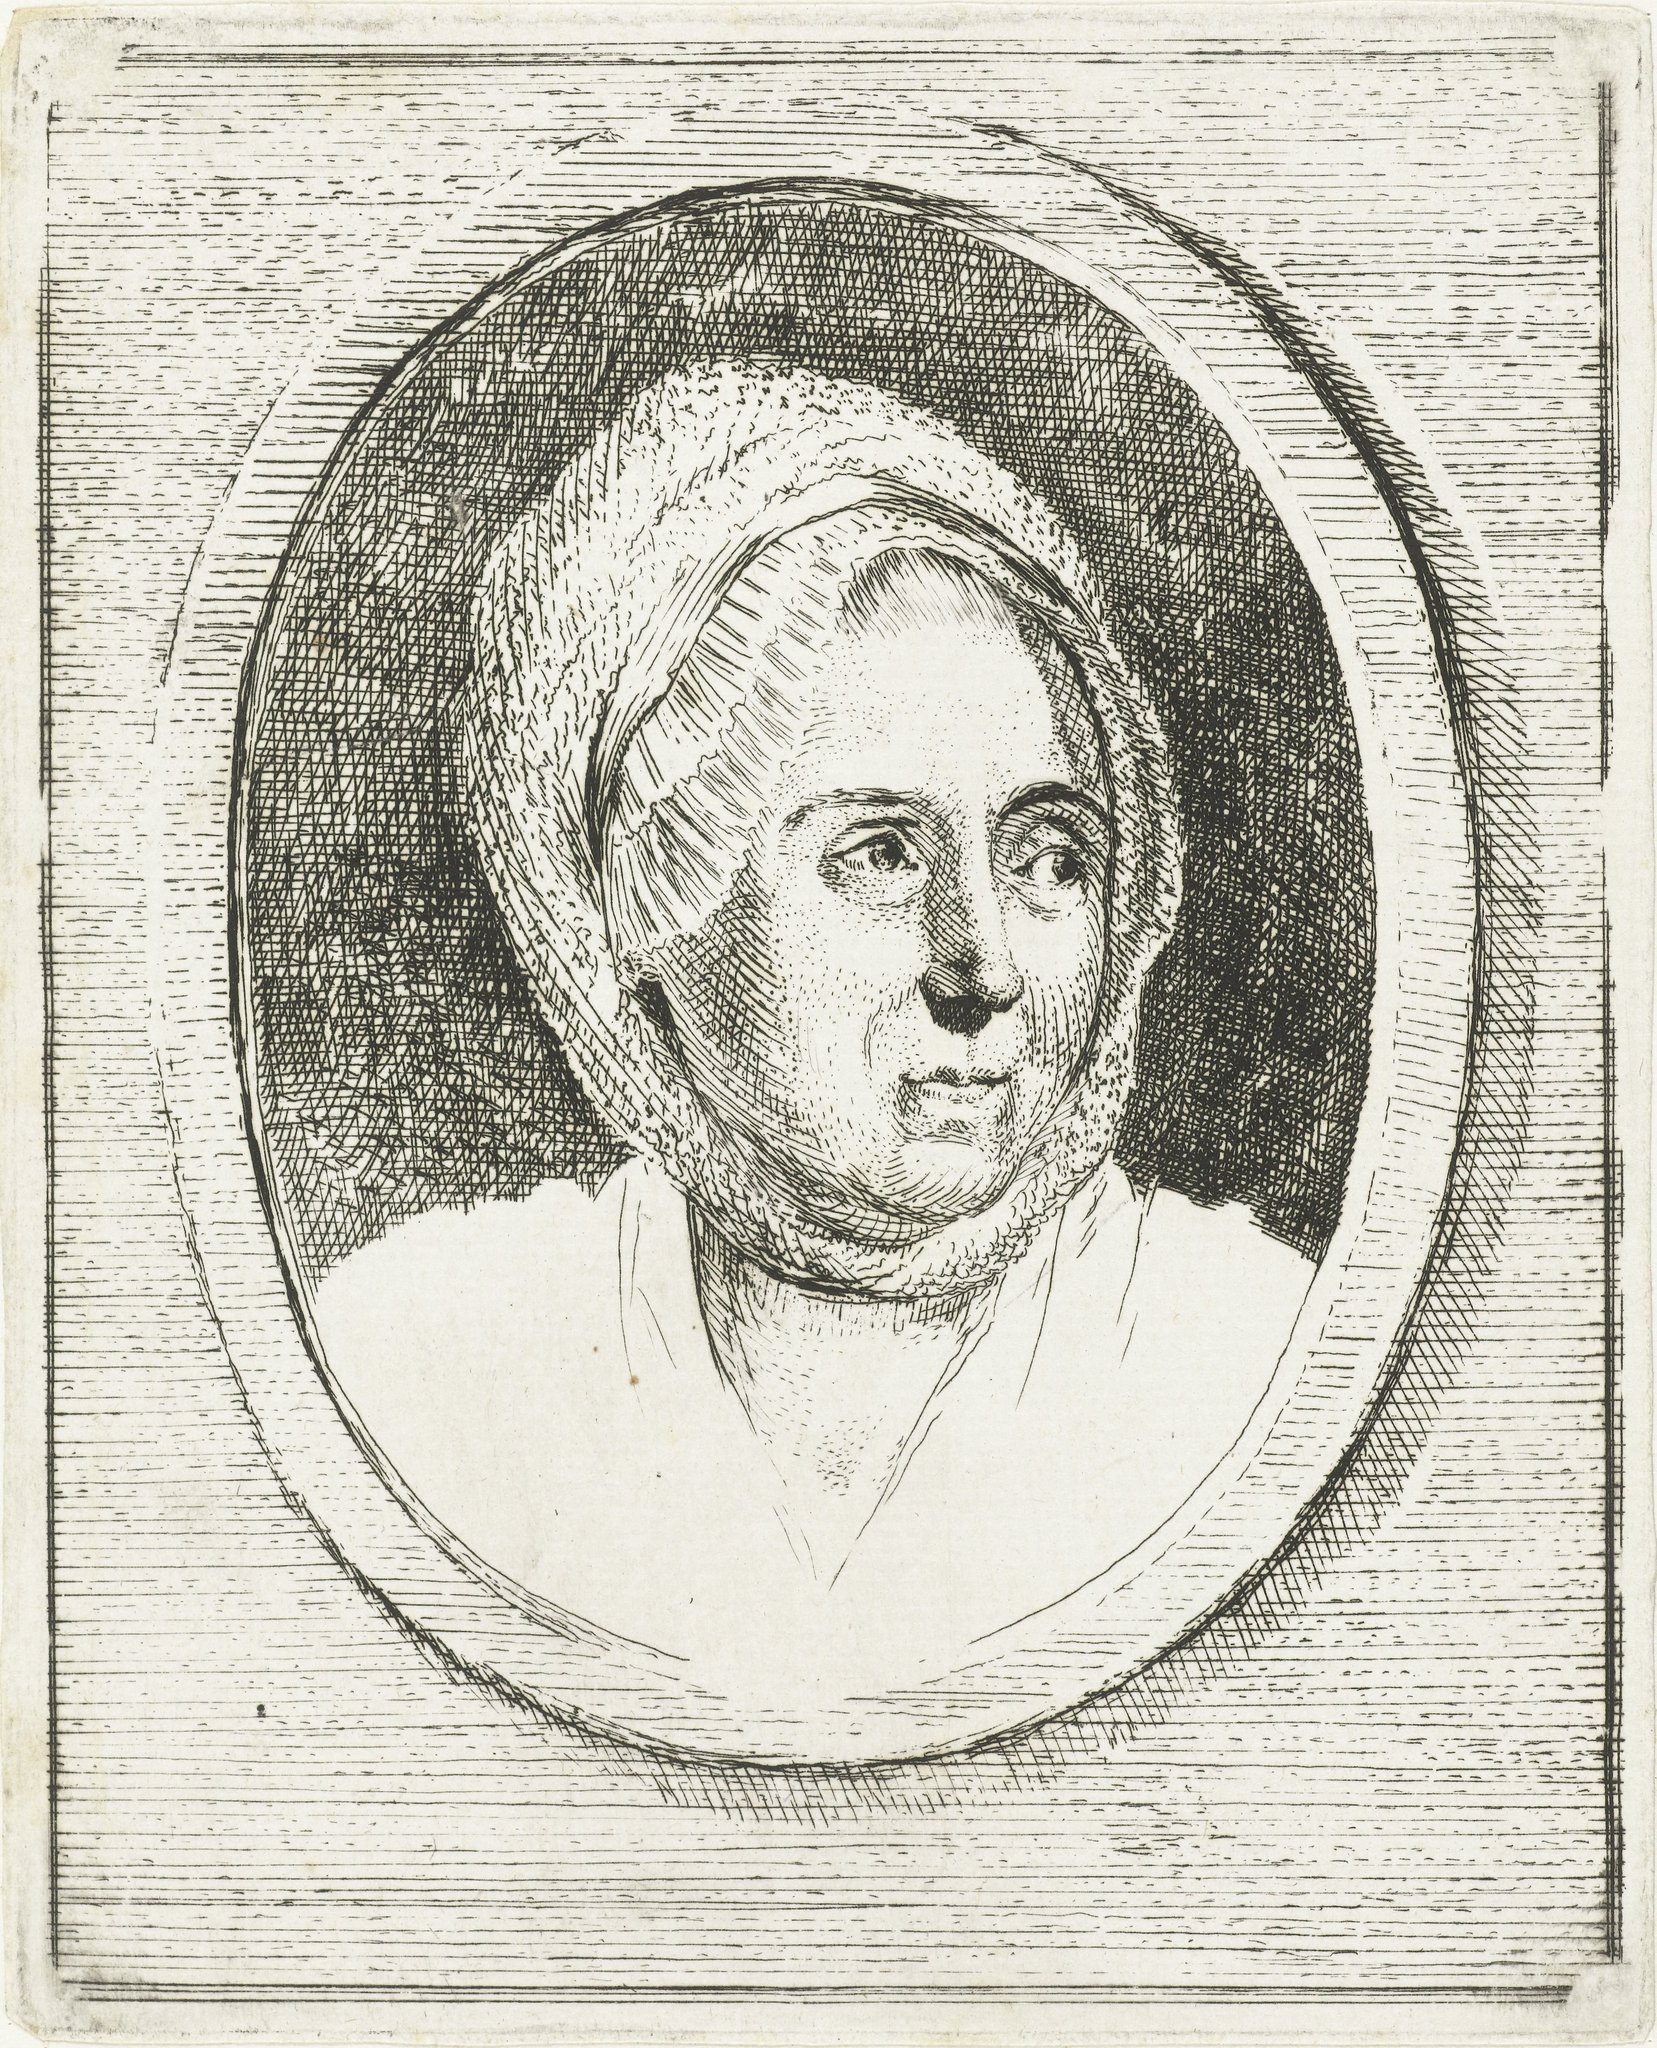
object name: print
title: Portret van een vrouw met kapje (Marie Joseph Bertrand?)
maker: louis bernard coclers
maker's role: draughtsman, print maker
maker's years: 1741-1817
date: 1756-1817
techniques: drypoint, etching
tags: anonymous historical person portrayed alone - bb - woman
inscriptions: collector's mark: Lugt 2228